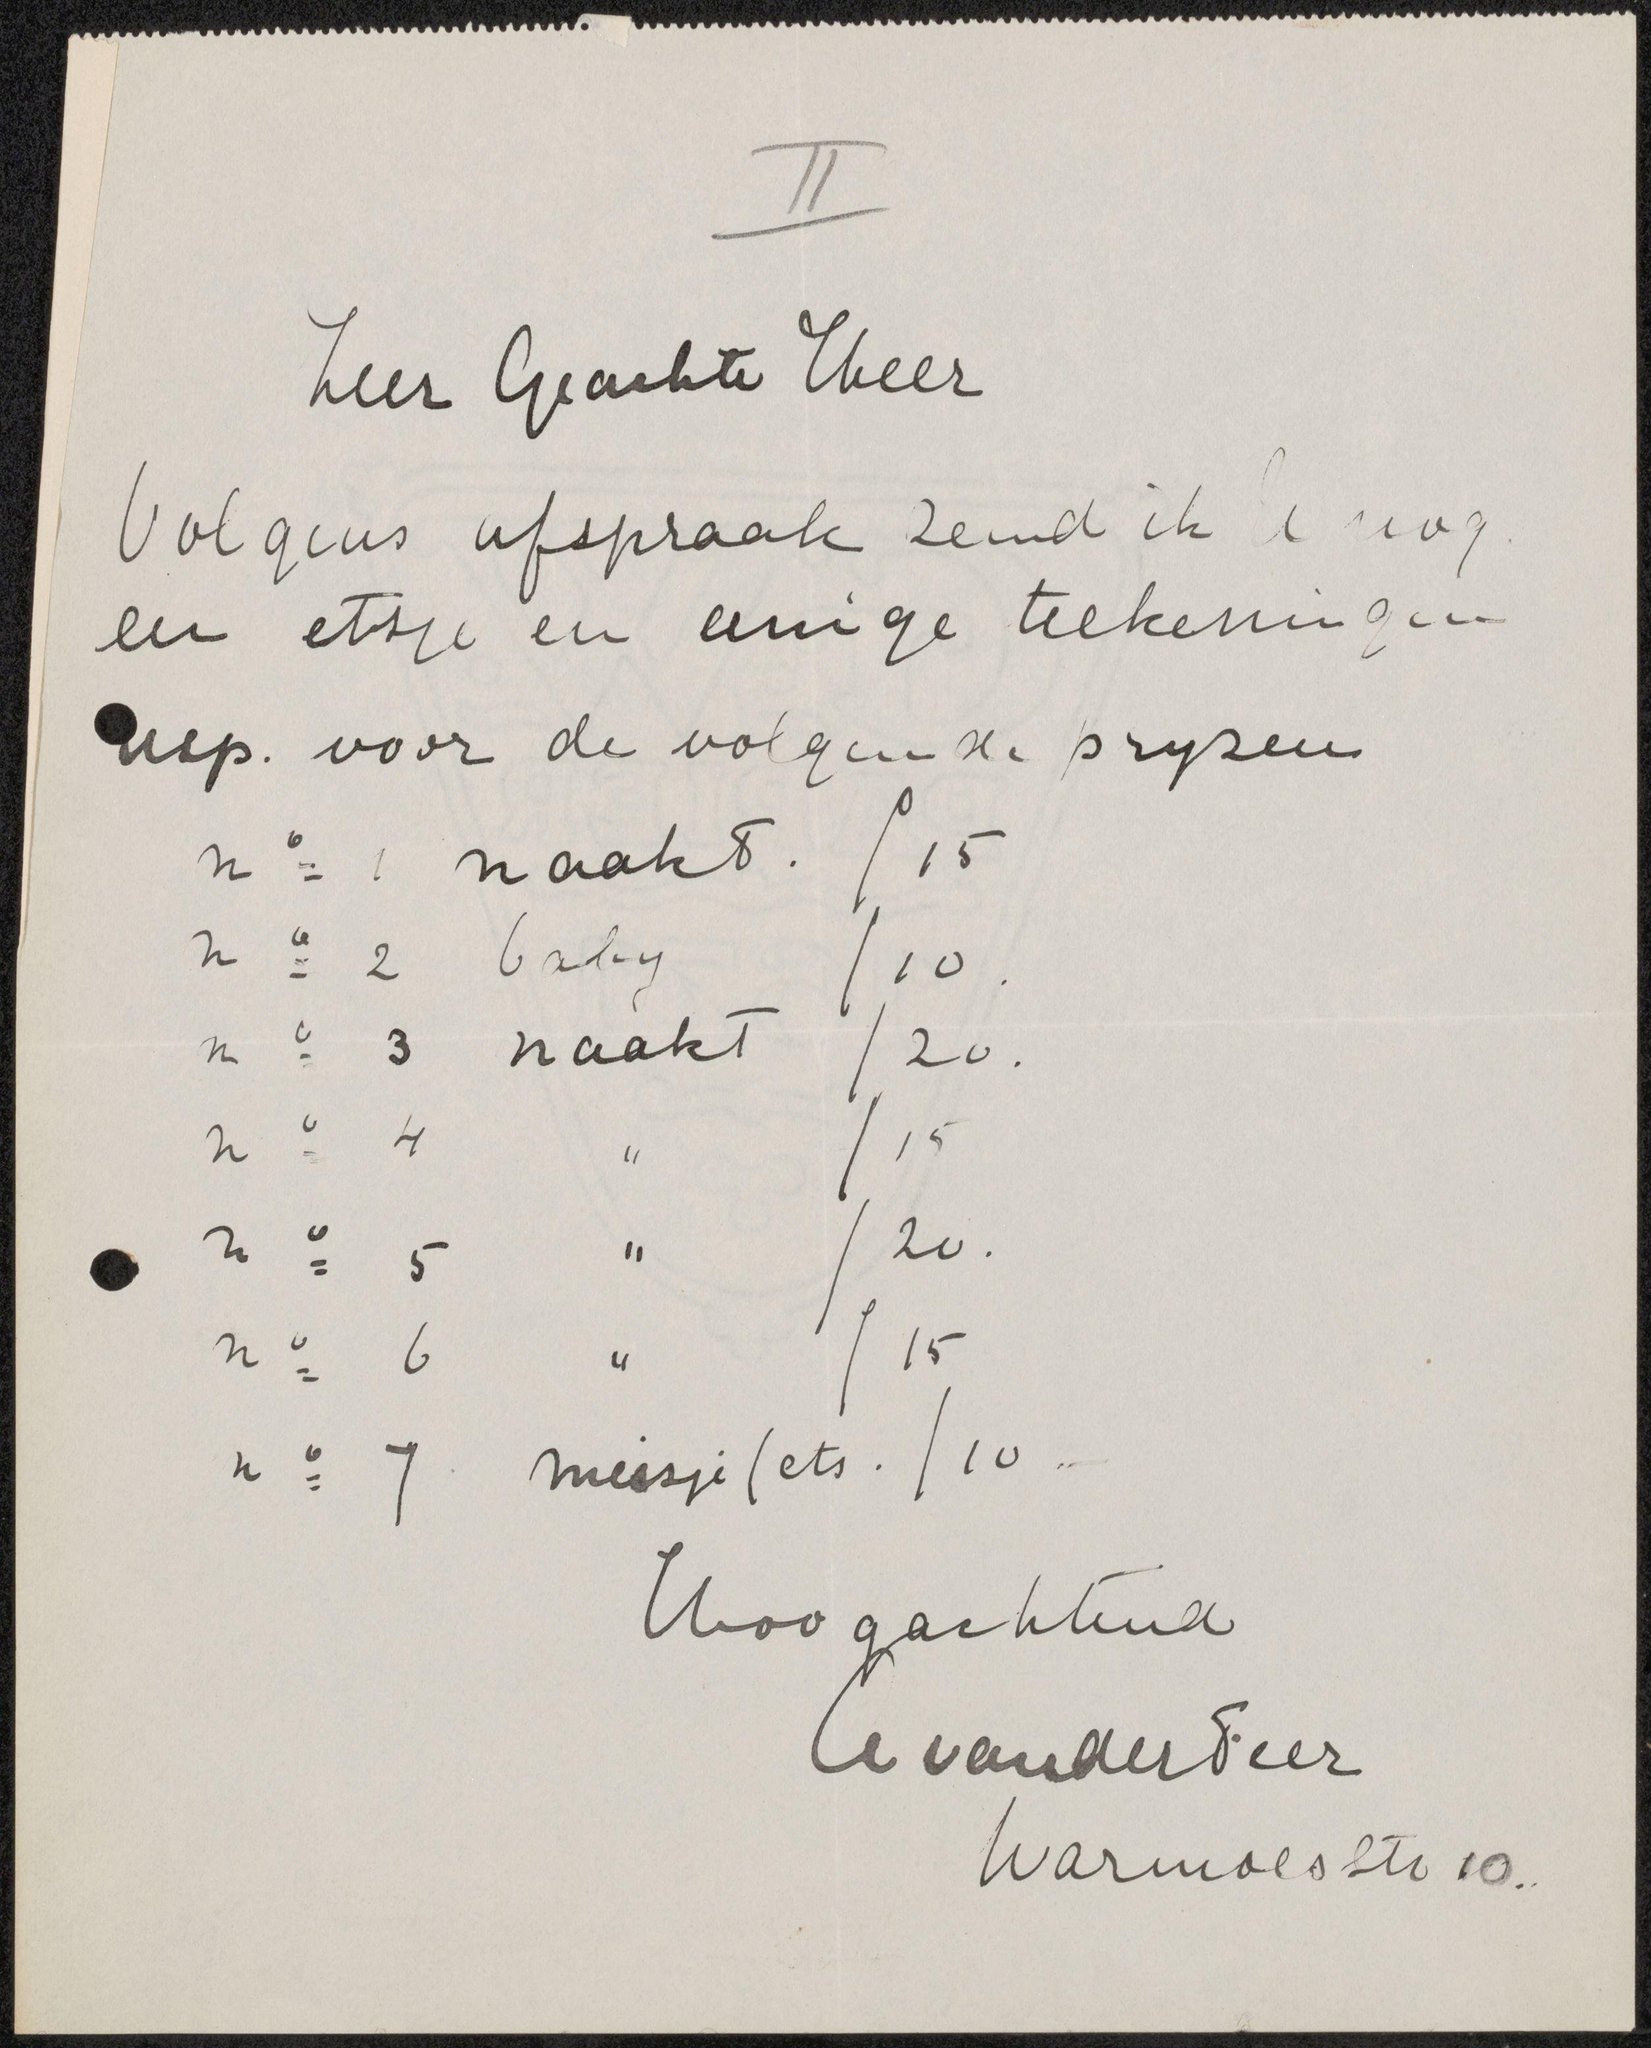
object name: letter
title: Brief aan jonkheer Hendrik Teding van Berkhout (1879-1969)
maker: anneke van der feer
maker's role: draughtsman, print maker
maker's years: 1902-1956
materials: ink, paper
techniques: pen, writing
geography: amsterdam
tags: haarlem, amsterdam, jonkheer hendrik teding van berkhout (1879-1969), drawing, the graphic arts, money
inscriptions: watermark, collector's mark: ‘RPK’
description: De tekeningen onder gerelateerd object worden genoemd in de brief.